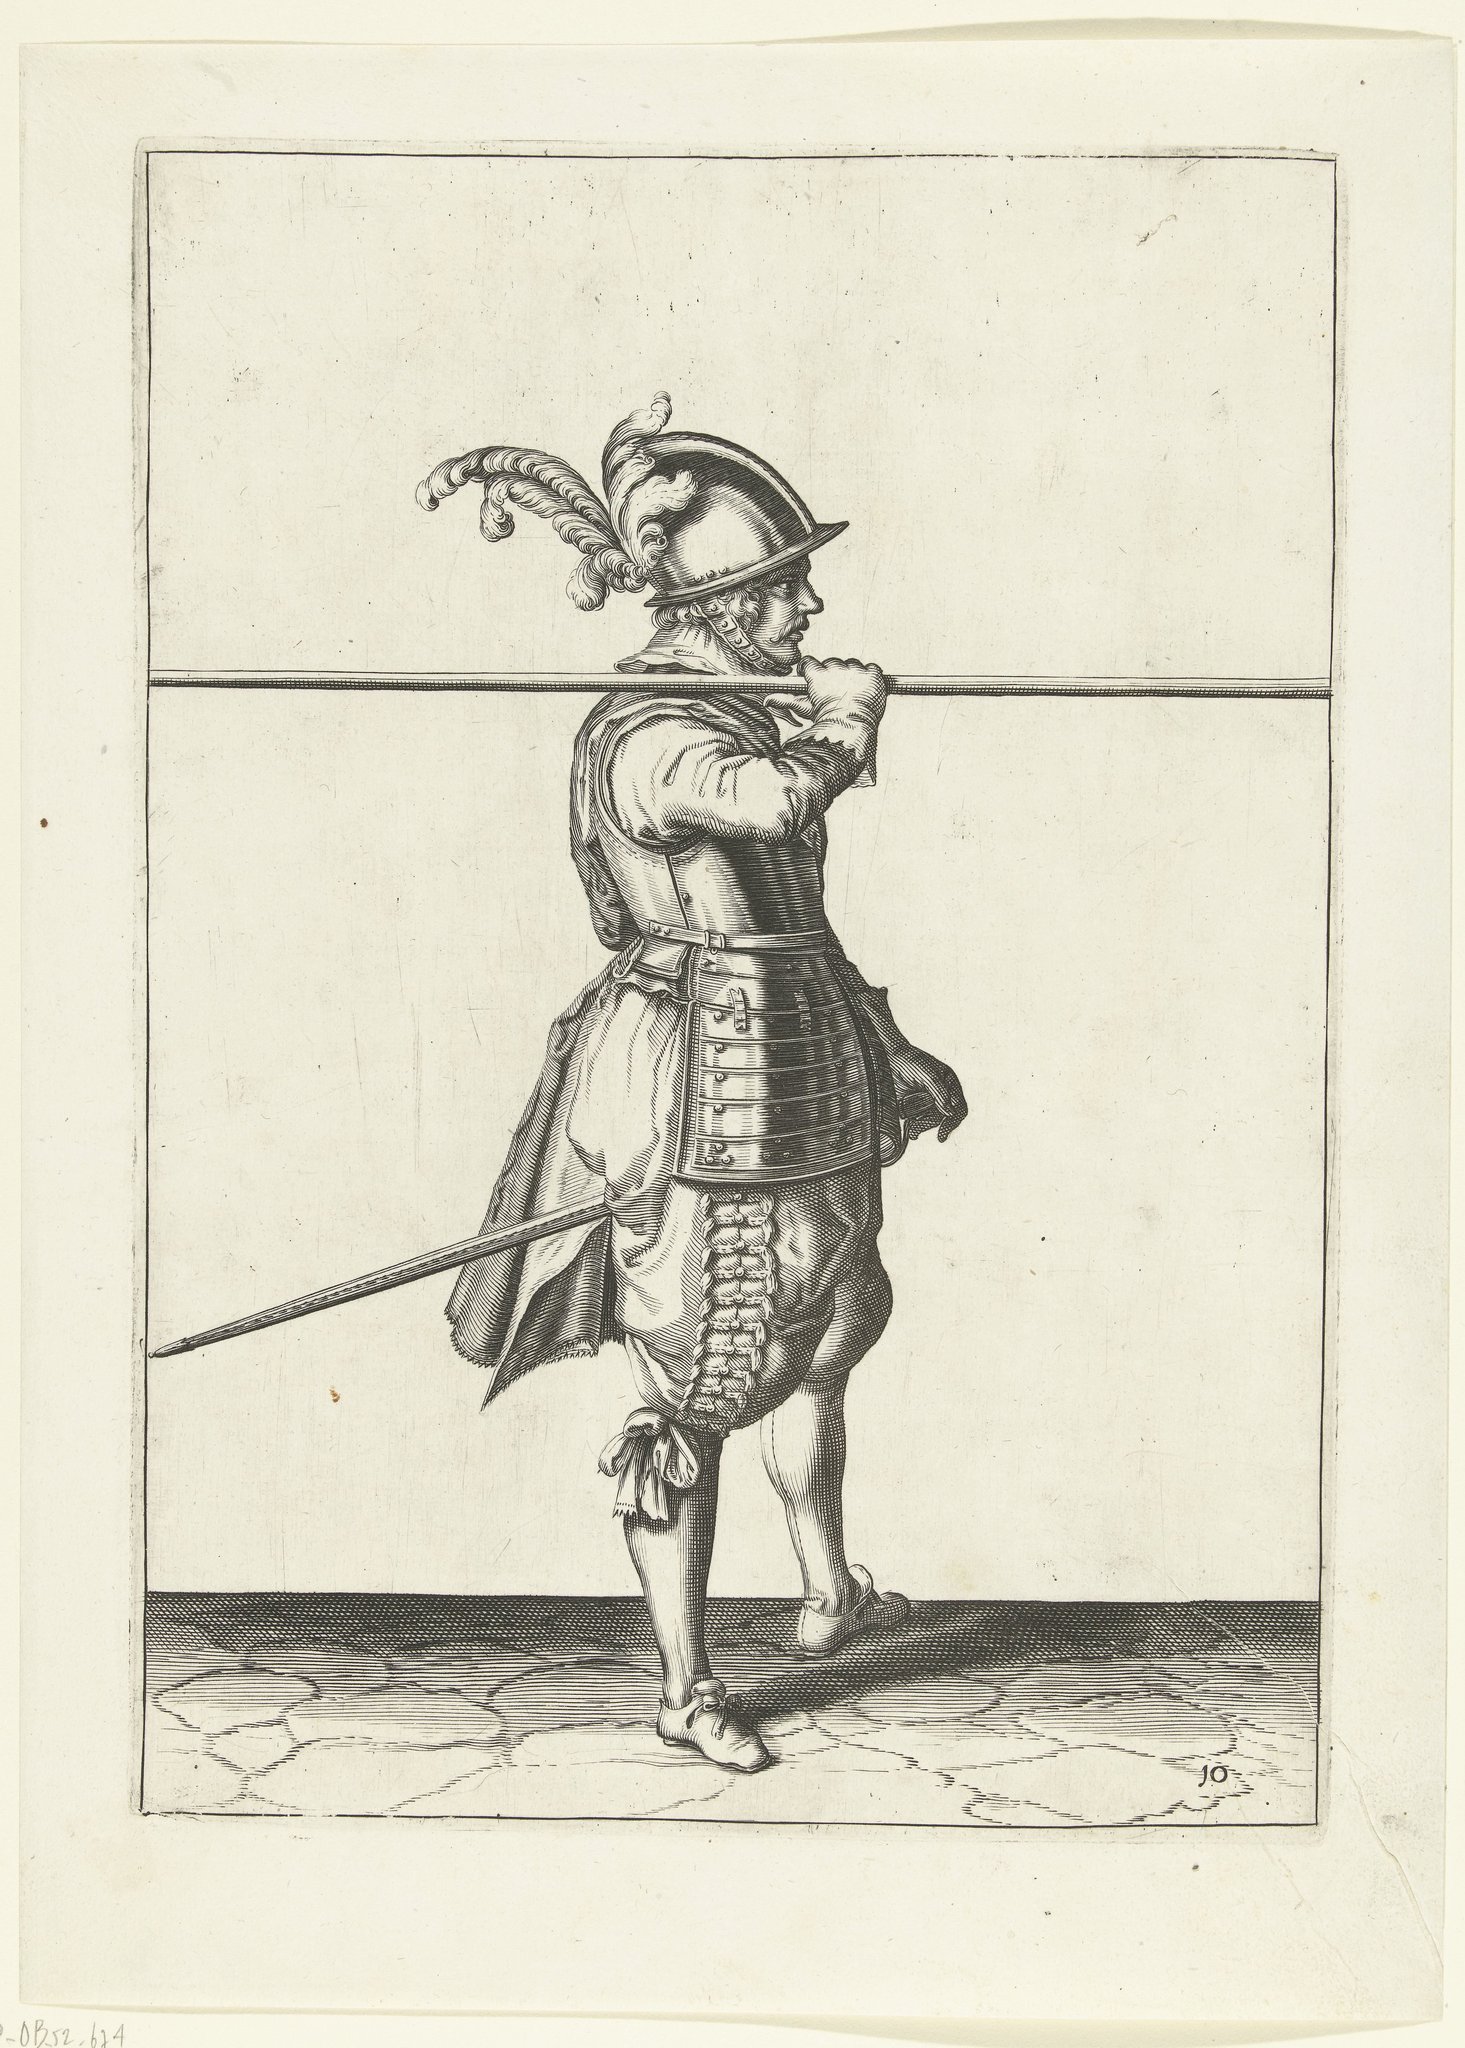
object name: print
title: Wapenhandelinghe van Roers Musquetten ende Spiessen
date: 1597-1607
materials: paper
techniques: engraving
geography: netherlands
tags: manoeuvre ~ military training, warfare; military affairs (+ mercenary troops, e.g.: lansquenets), helved weapons, polearms (for striking, hacking, thrusting): lance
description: Een soldaat, ten voeten uit, naar rechts, die een spies (lans) horizontaal op zijn rechterschouder draagt. Zijn rechterhand om de spies. Dit is de derde handeling voor het opheffen van de spies naar de schouder en het horizontaal dragen ervan. Deze prent is onderdeel van de reeks van 32 genummerde prenten van spiesdragers uit de Wapenhandelinghe.